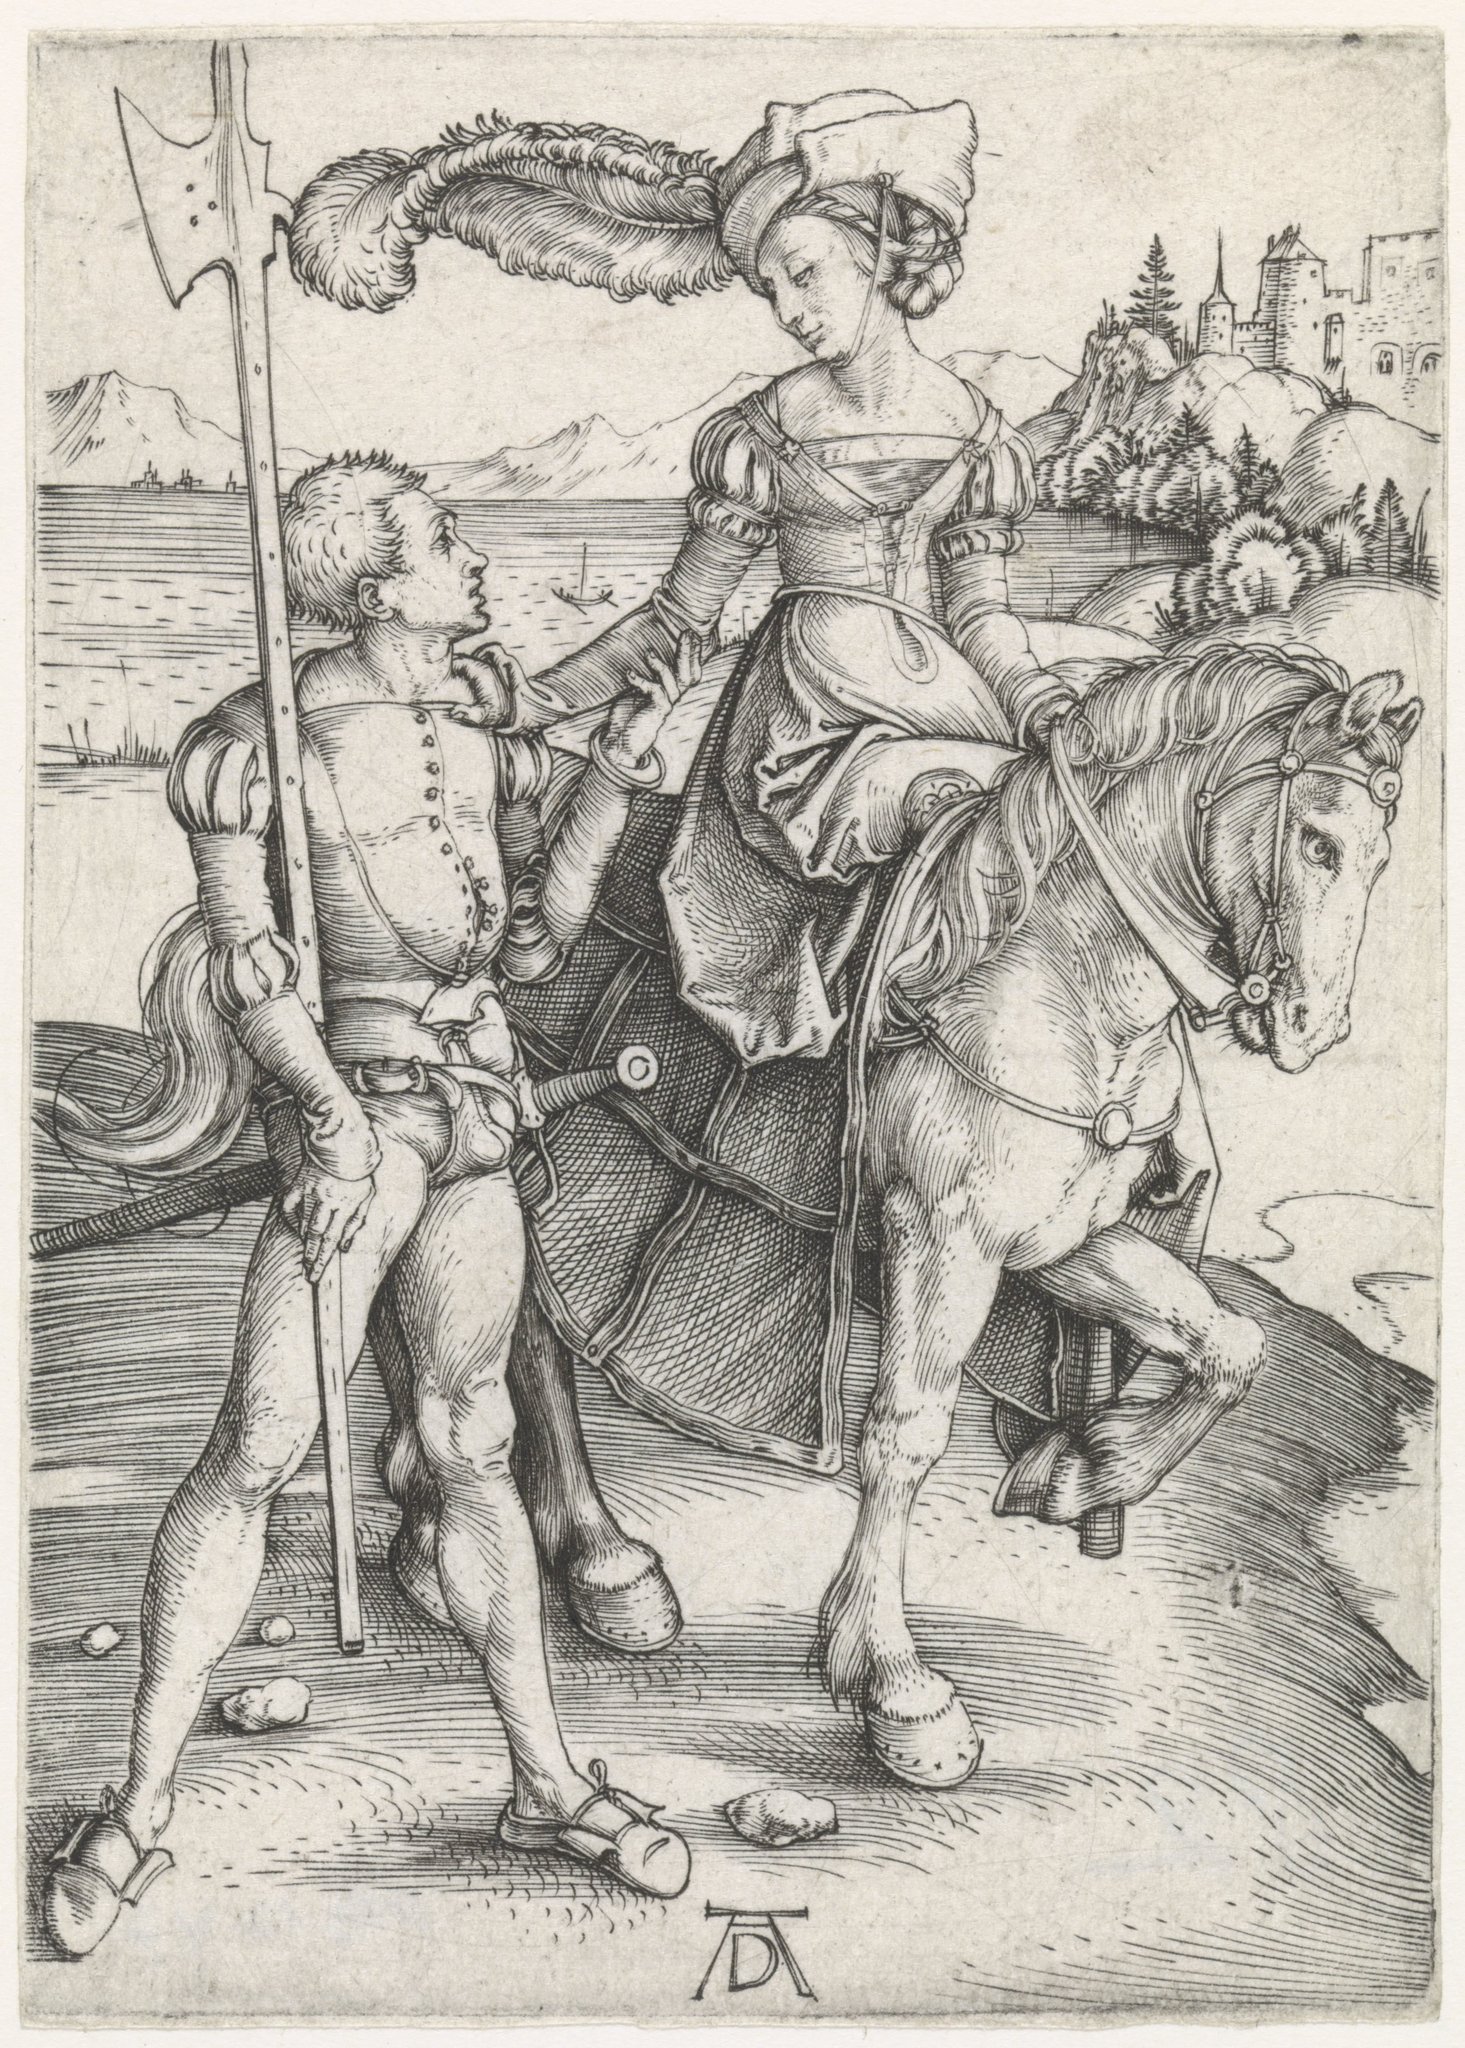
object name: print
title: Vrouw te paard en soldaat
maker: albrecht dürer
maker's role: draughtsman, painter, print maker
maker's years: 1471-1528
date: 1495-1499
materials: paper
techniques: engraving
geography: nuremberg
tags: riding a horse, ass, or mule; rider, horseman, clothes, costume (+ women's clothes), head-gear: hat (+ women's clothes), dress, gown (+ women's clothes), warfare; military affairs (+ mercenary troops, e.g.: lansquenets), clothes, costume (+ men's clothes), shoes, sandals, trousers, breeches, etc. (breeches) (+ men's clothes), clothing for the upper part of the body (doublet) (+ men's clothes), head-gear: hat (+ feathers used for clothes), helved weapons, polearms (for striking, hacking, thrusting): halberd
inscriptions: monogram: ‘AD’, collector's mark: Lugt 2228a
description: Amazone, op het kapsel met vlechten een muts met omgeslagen rand en grote struisveer. Zij draagt een japon met kopmouwen met splitten. De landsknecht met hellebaard, die naast het paard loopt, draagt een wambuis met knoopsluiting en mouwen met splitten, schaambedekking en beenlingen met een buidel. Aan zijn voeten schoenen met ronde neuzen en vetersluiting. Datering kleding: 1490-1500.